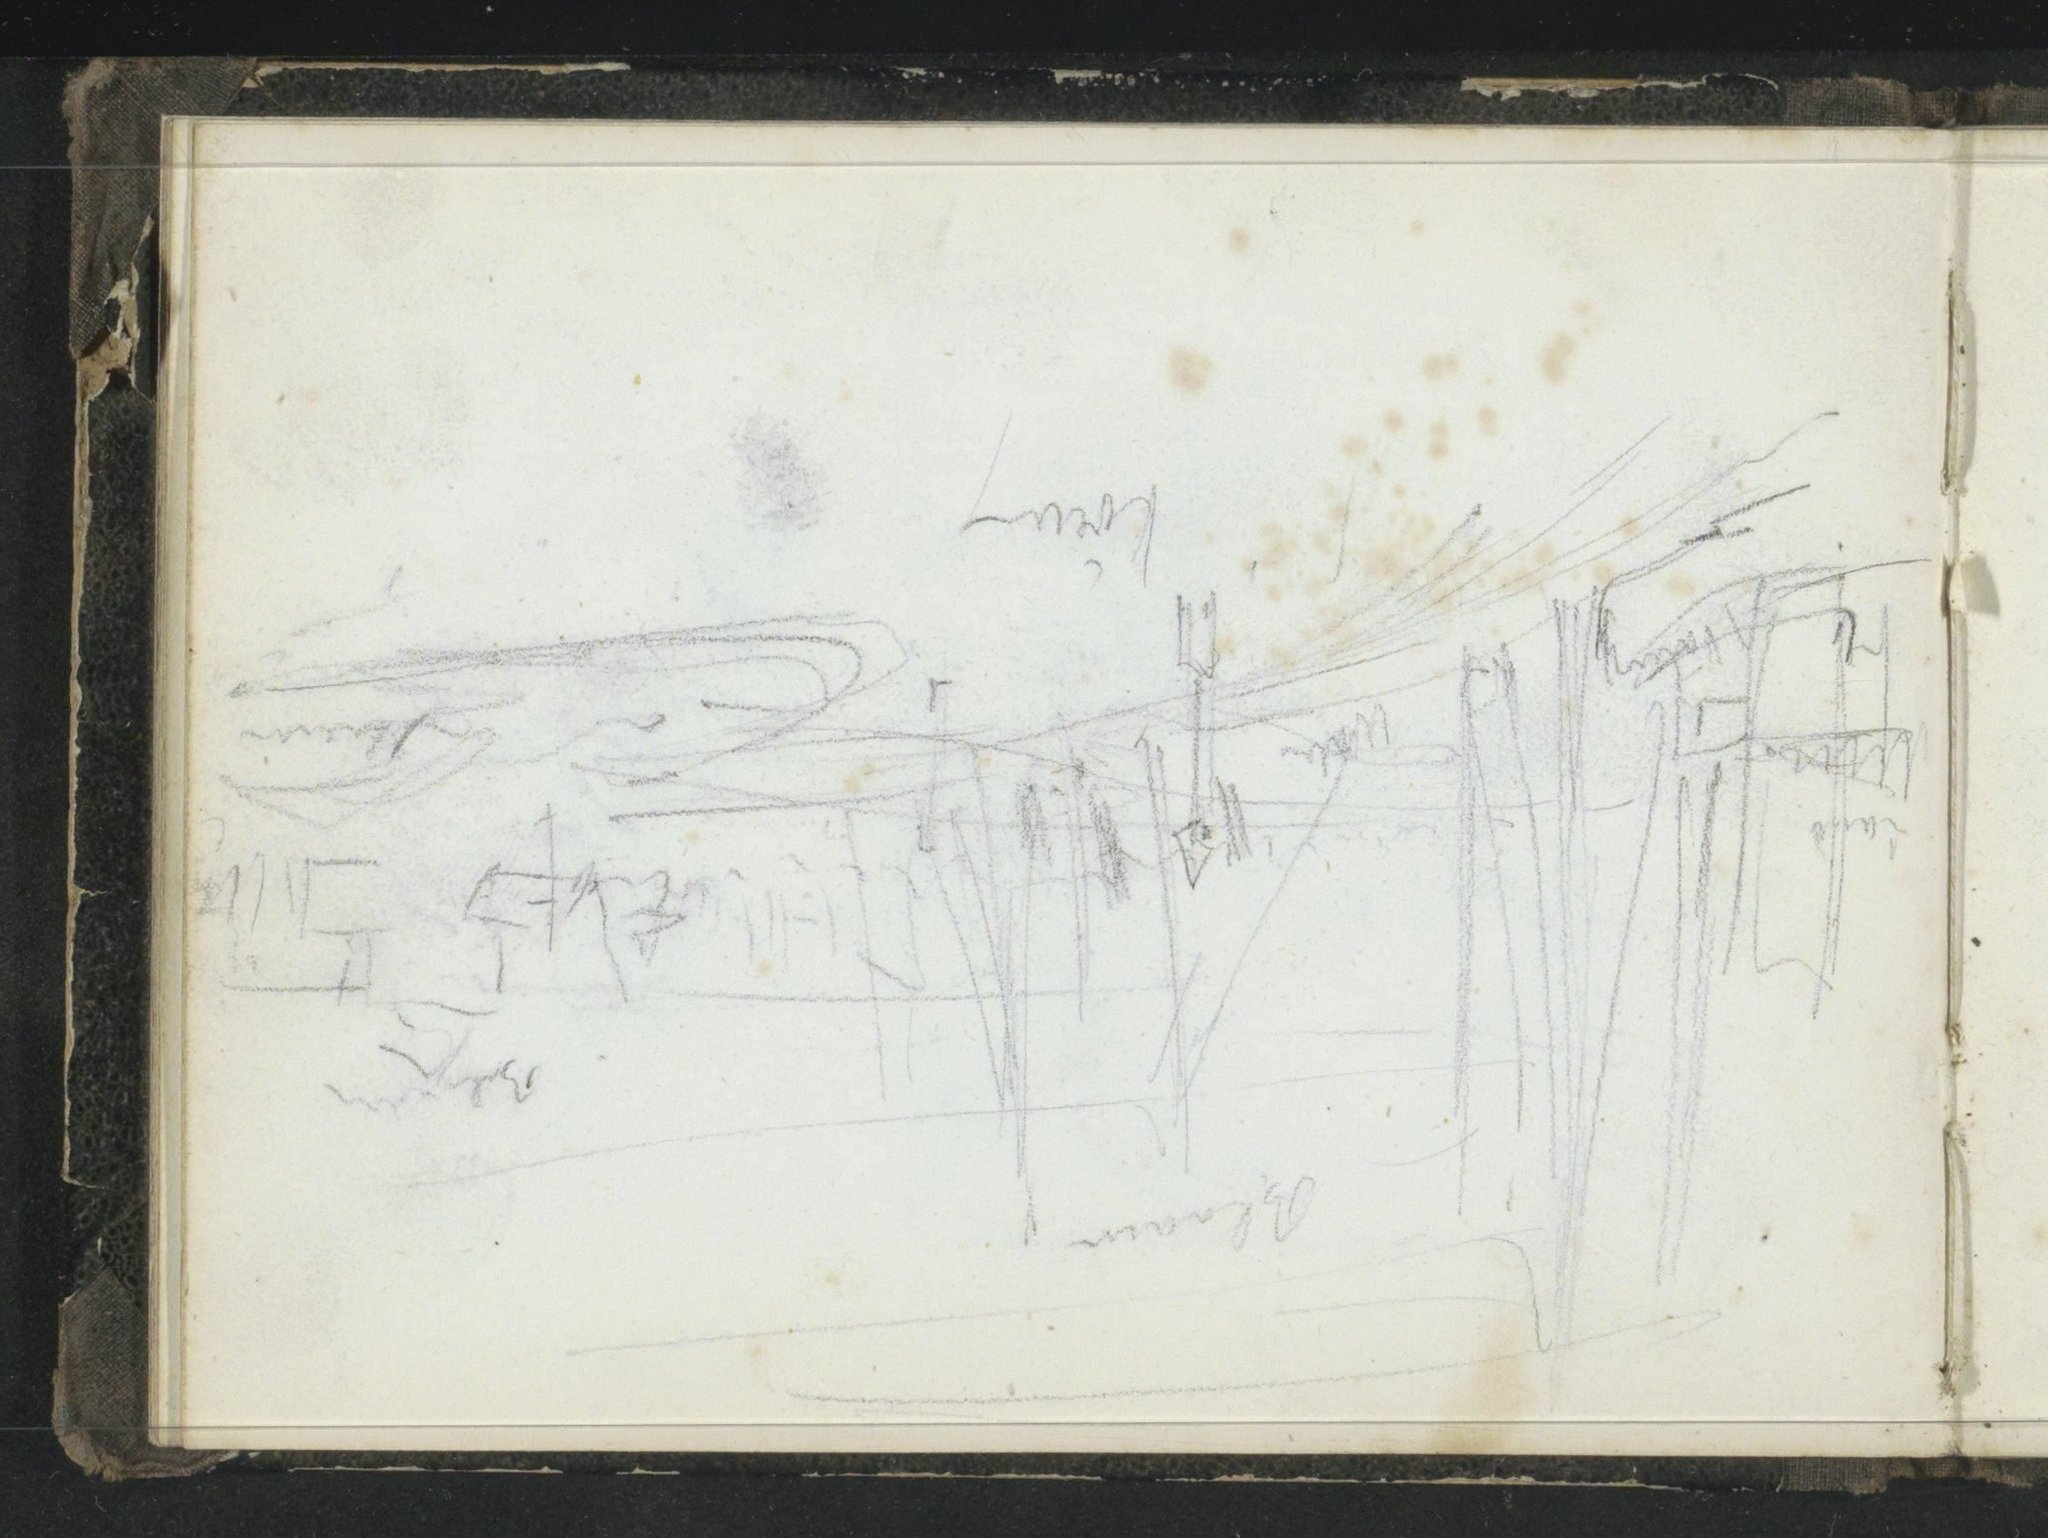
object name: sketchbook leaf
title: Landschap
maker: theo hanrath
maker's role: draughtsman, painter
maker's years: 1853-1883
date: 1879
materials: paper, pencil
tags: landscapes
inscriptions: kleurnotitie, handgeschreven in potlood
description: Blad 7 verso uit een schetsboek met 27 bladen.